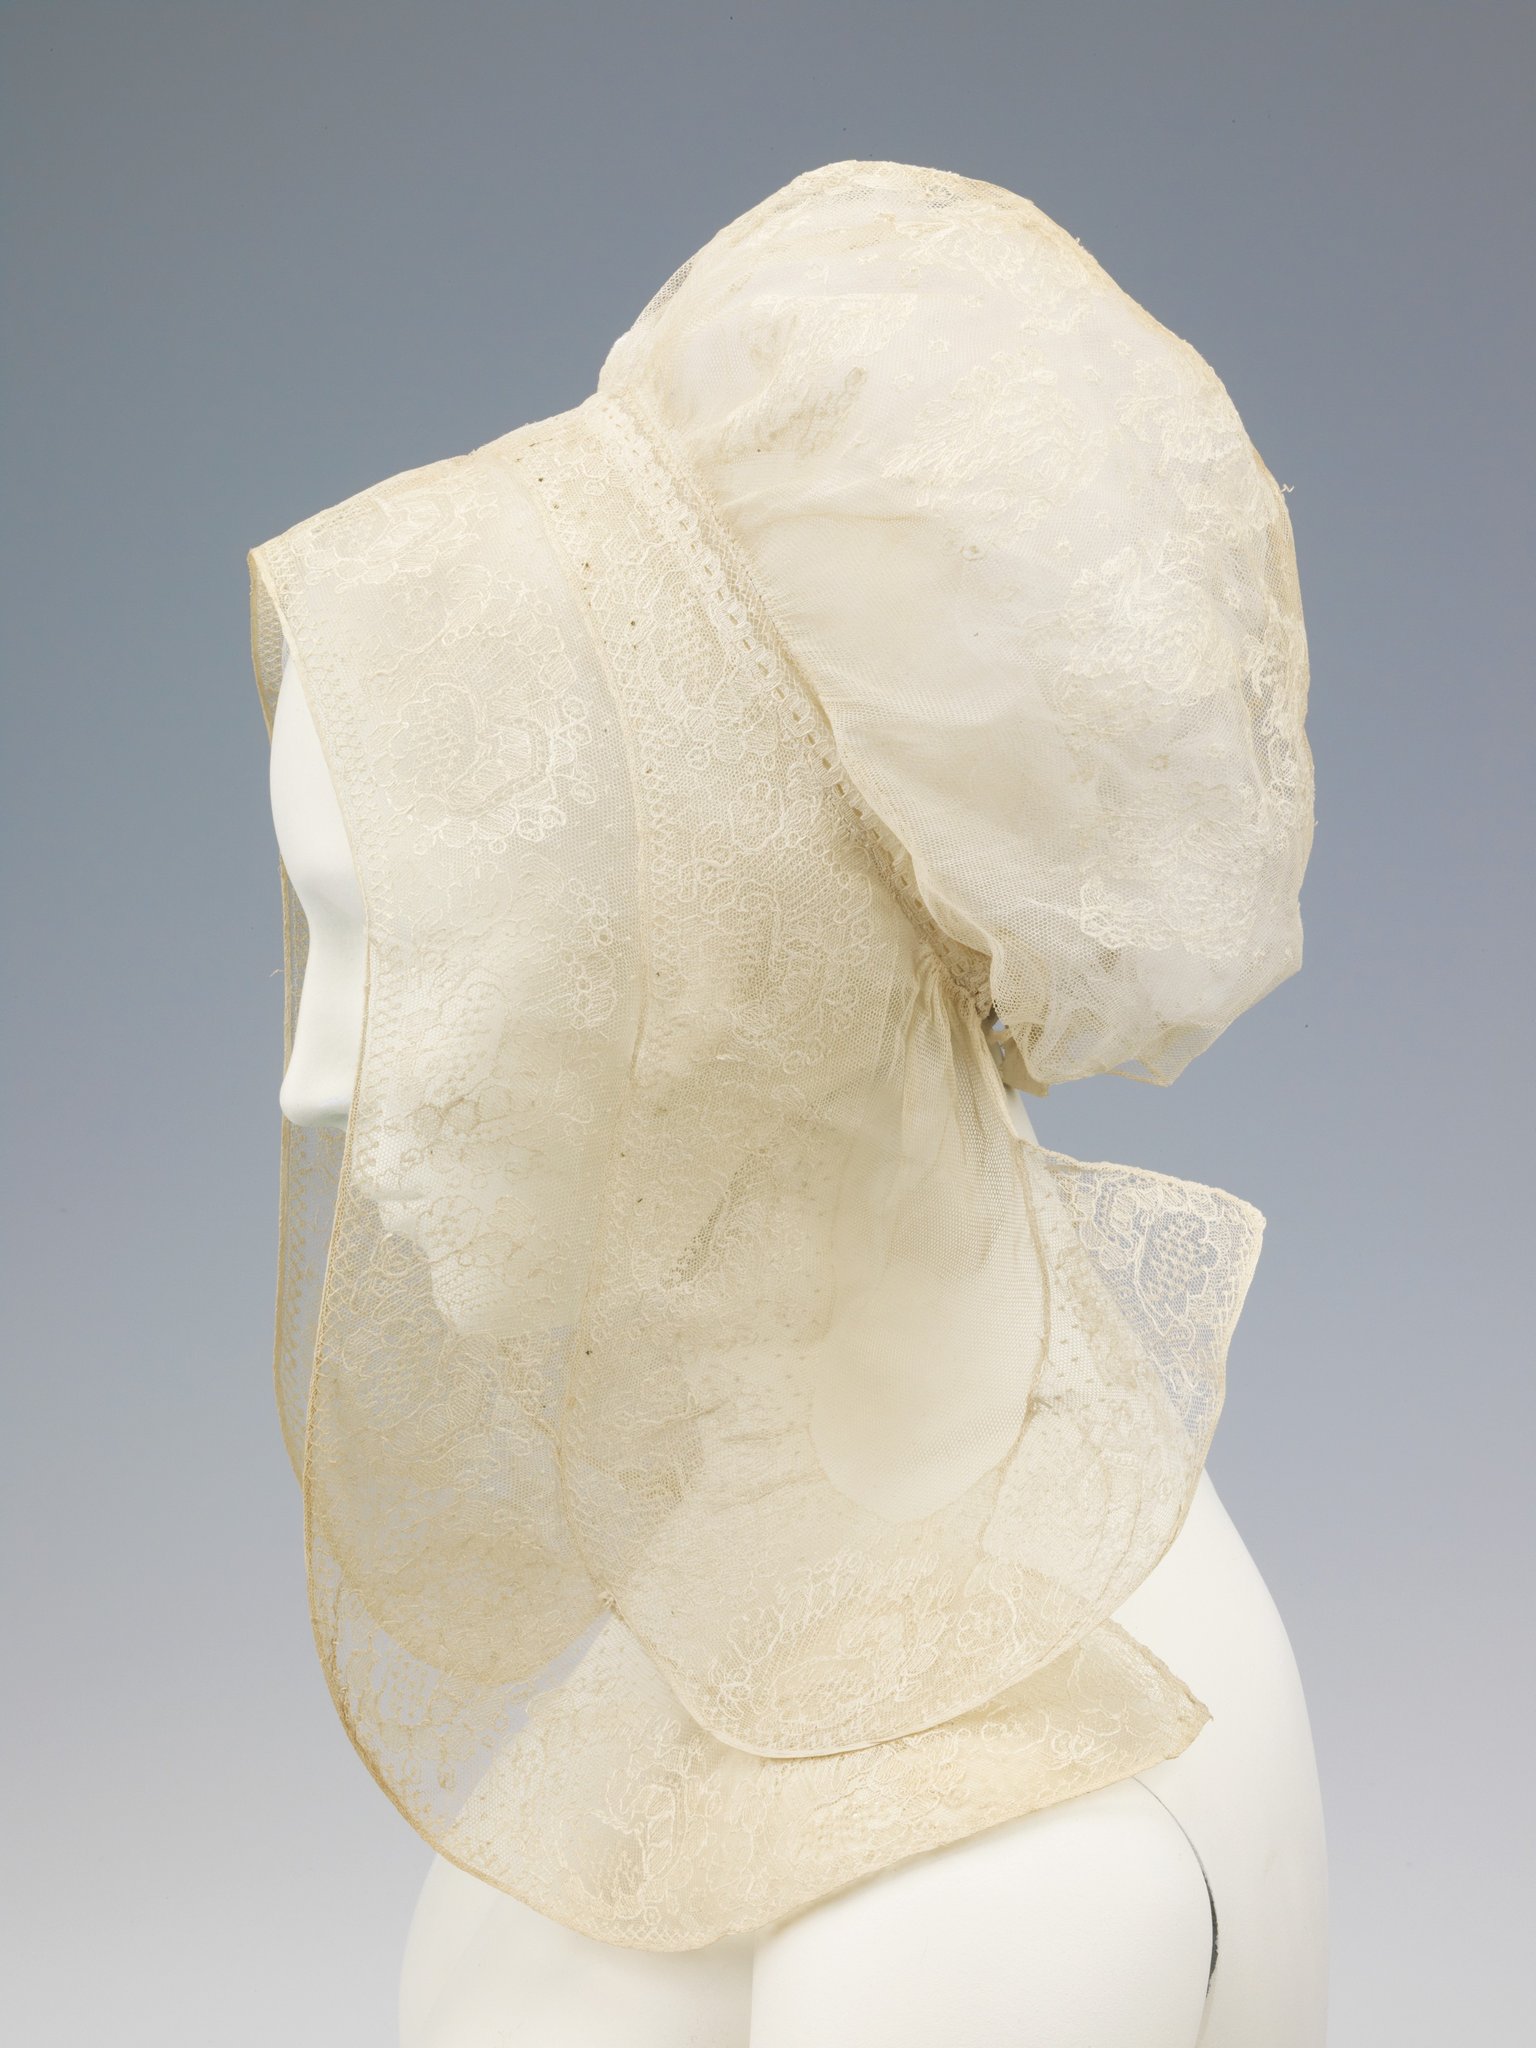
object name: bonnet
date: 1800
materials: cotton, linen